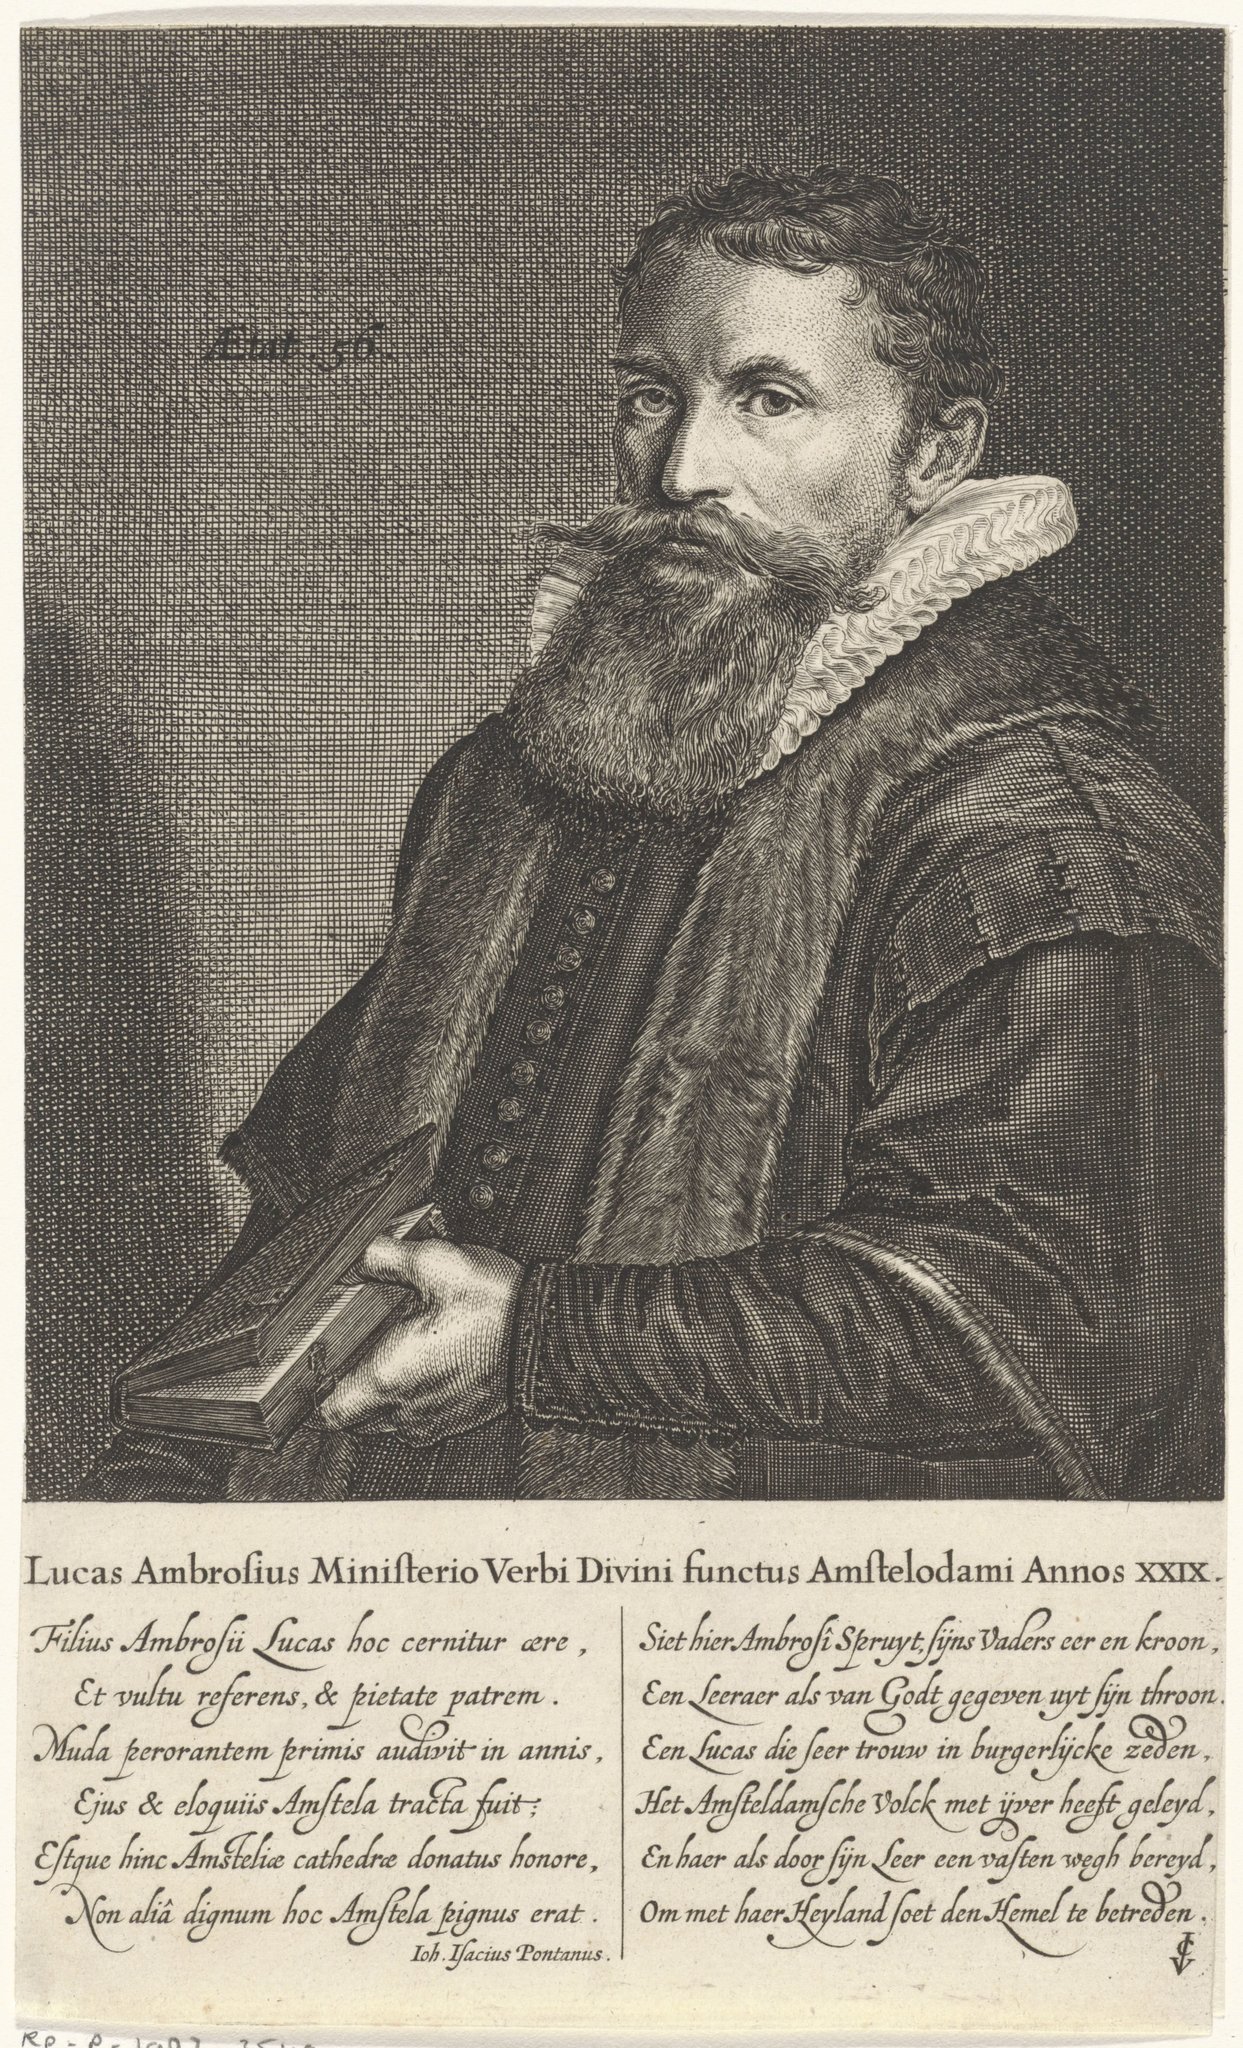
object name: print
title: Portret van Lucas Ambrosius, predikant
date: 1610-1652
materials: paper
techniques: engraving, etching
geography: amsterdam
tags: lucas ambrosius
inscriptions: collector's mark: Lugt 2228